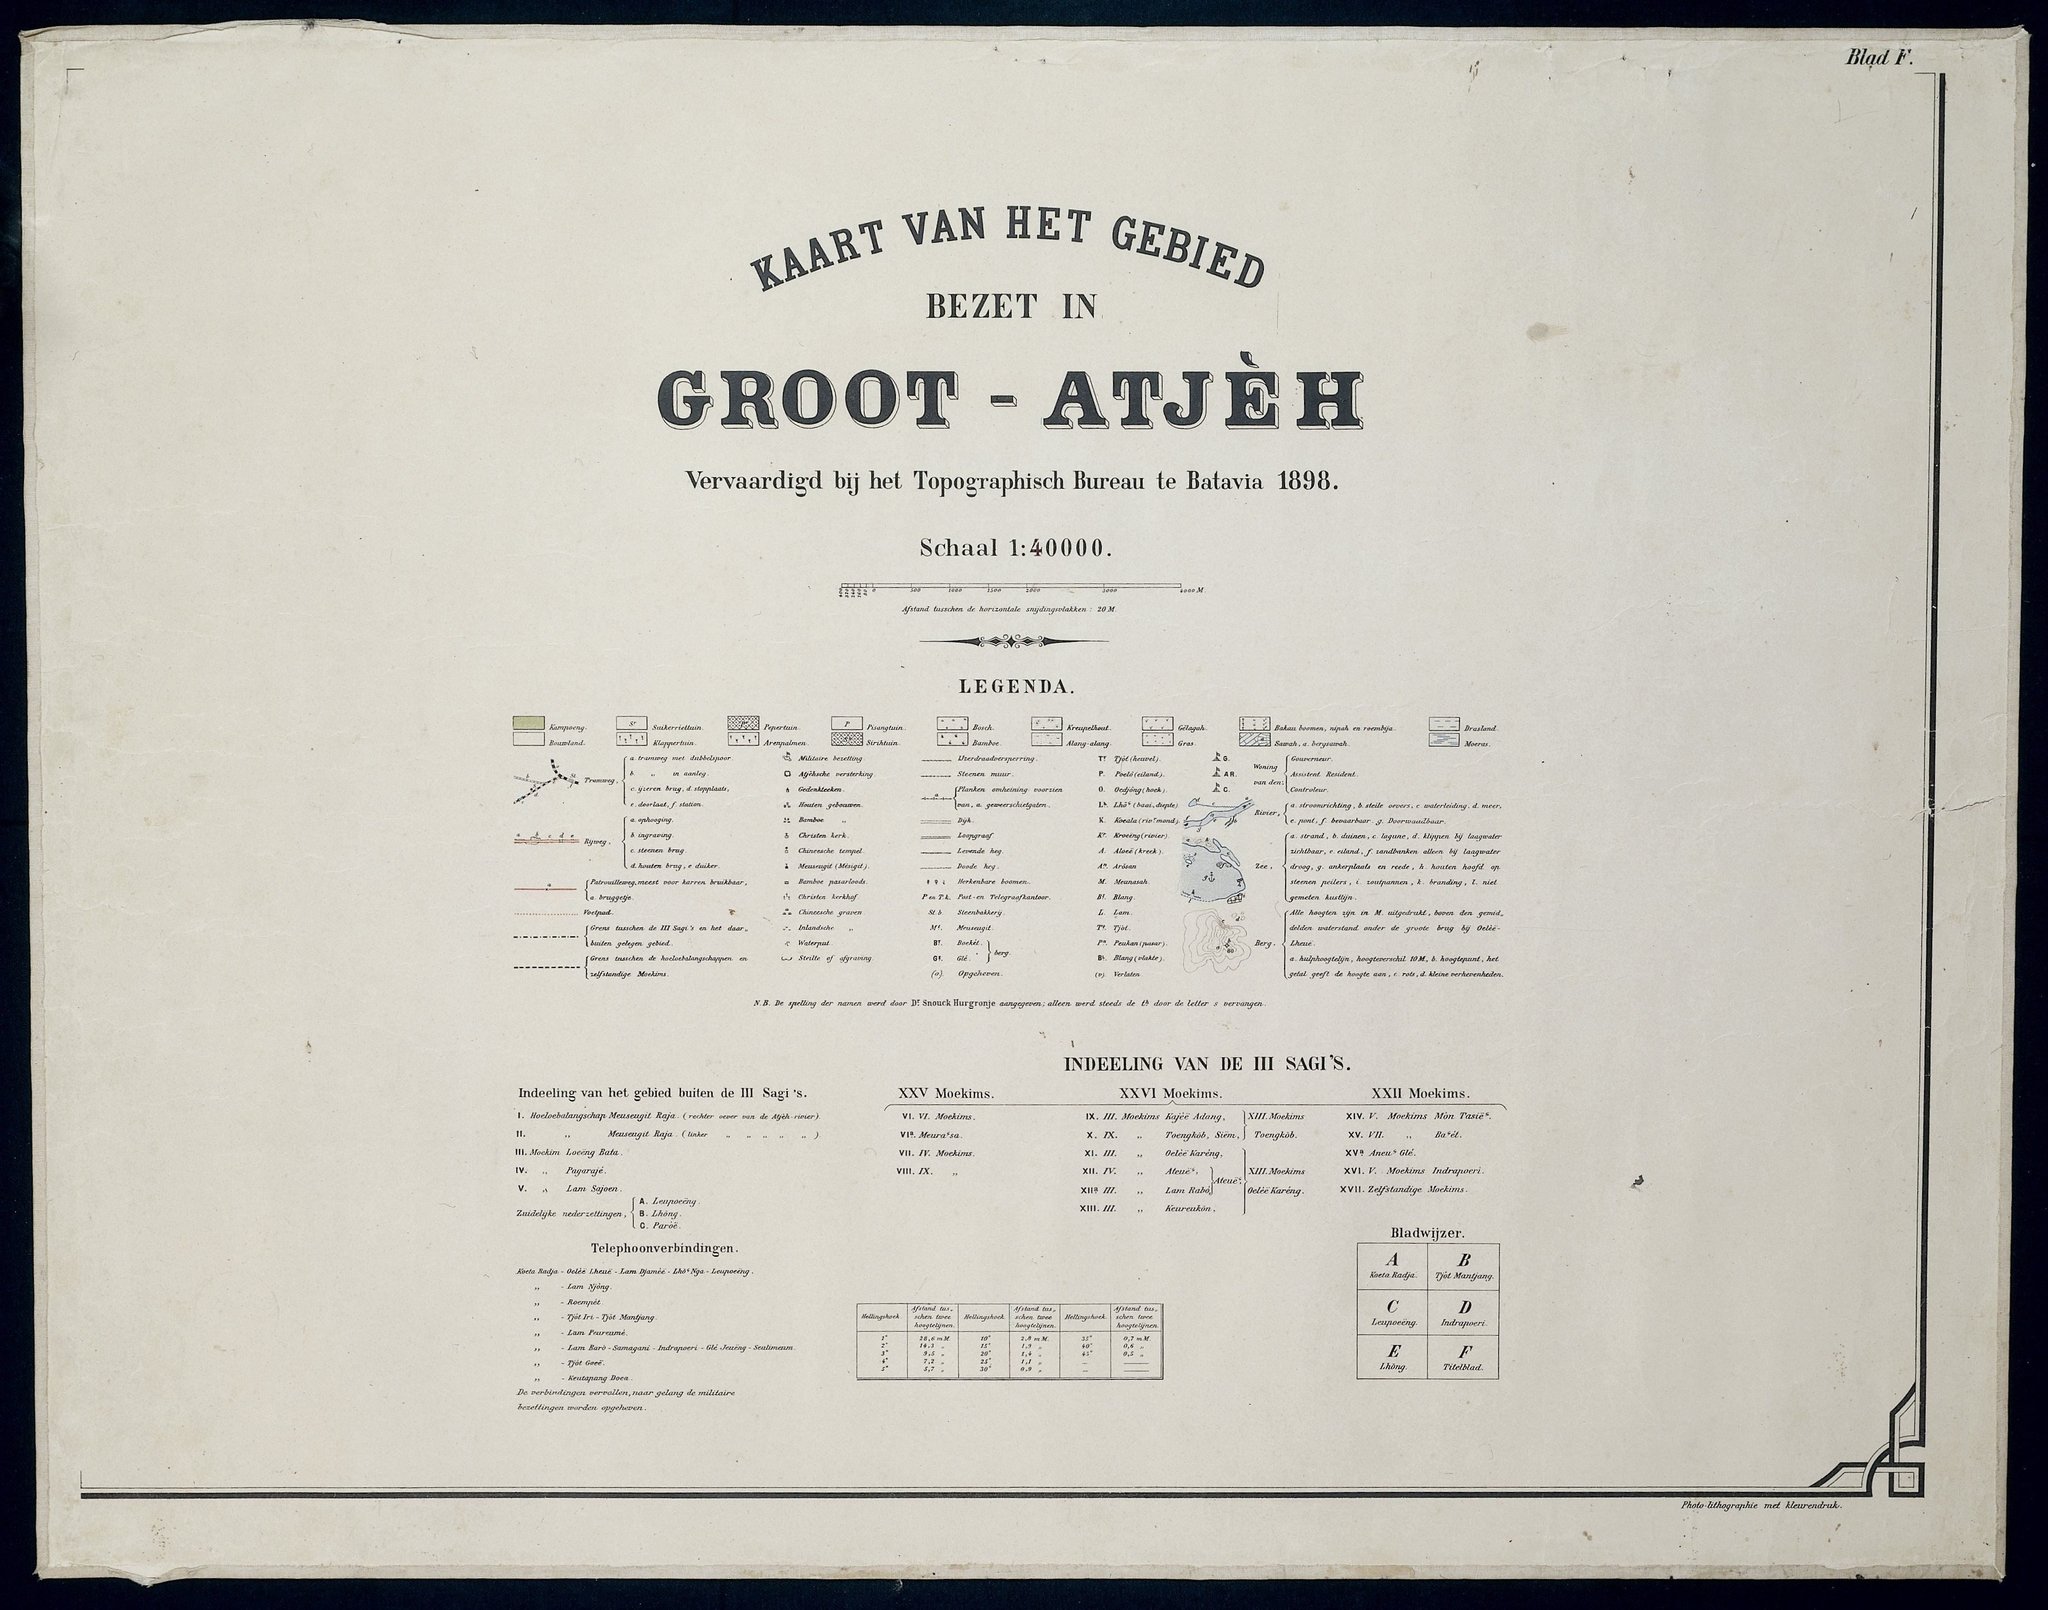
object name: map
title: Kaart van het gebied bezet in Groot-Atjèh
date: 1898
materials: linen, paper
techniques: printing, photolithography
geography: batavia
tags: maps of separate countries or regions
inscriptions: date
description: Landkaart van Groot-Atjeh, schaal 1:40.000, zes bladen, waarvan blad 1 met legenda en bladwijzer, en 5 kaartbladen. blad A: Suratte passage. blad B: grotendeels wit. blad C: grotendeels wit, links de Indische Oceaan en Ritieng Baai. blad D: onbekend. blad E: grotendeels wit, links de Indische Oceaan. Gedateerd; titelblad: 1898.